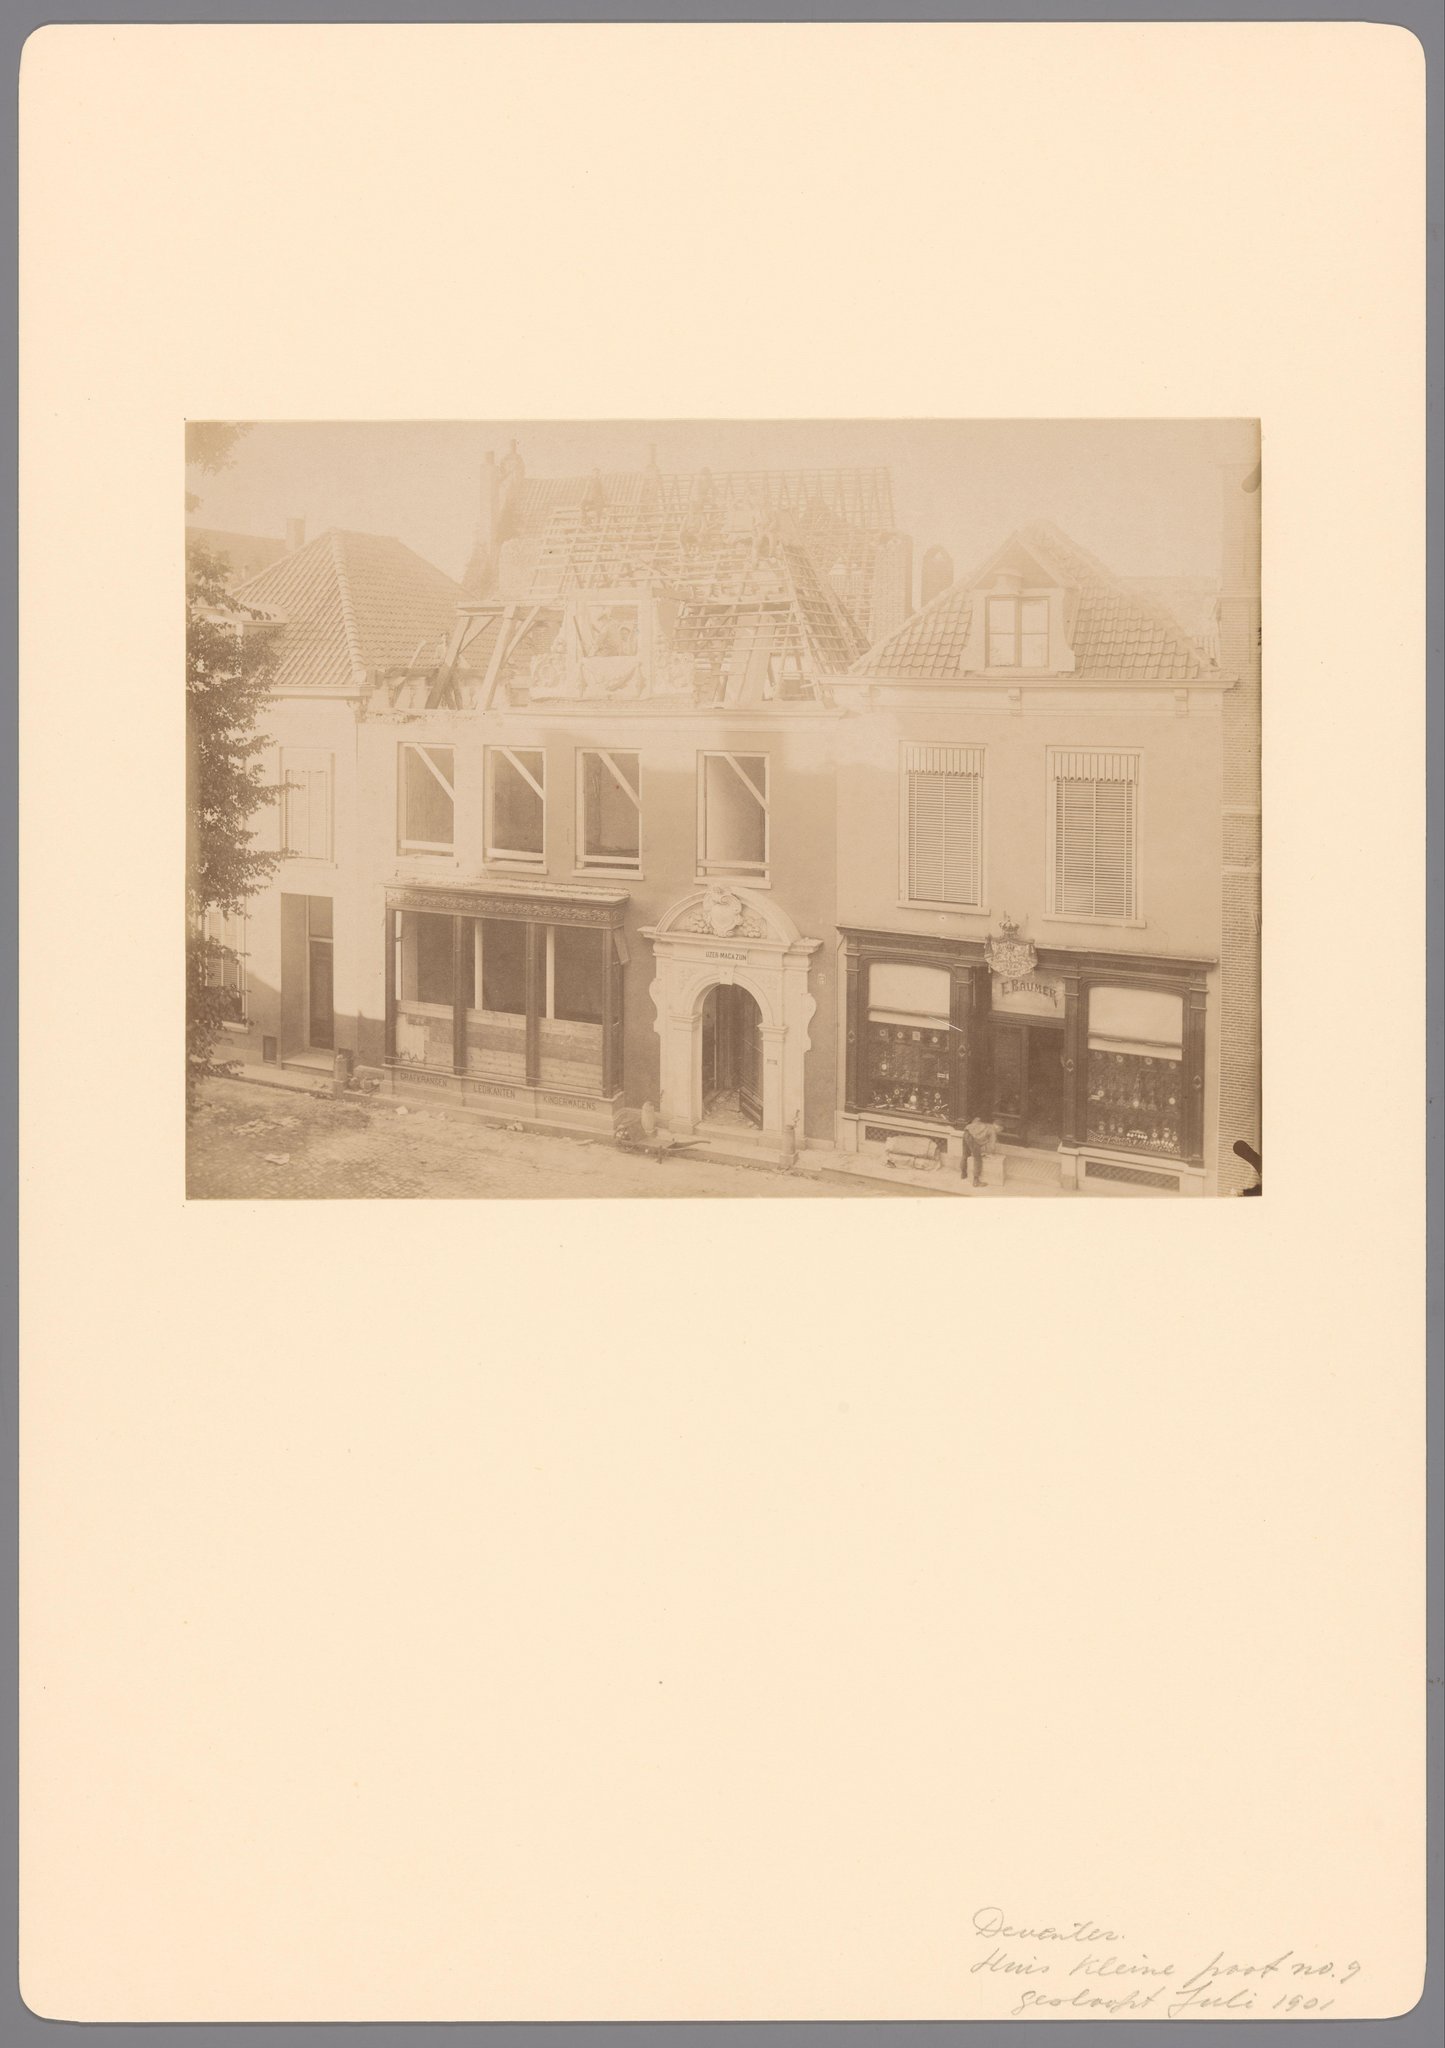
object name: photograph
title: Gezicht op Kleine Poot 9 te Deventer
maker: anoniem (monumentenzorg)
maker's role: fotograaf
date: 1901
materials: cardboard, photographic support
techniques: albumen print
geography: deventer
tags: urban housing, façade (of house or building), street (+ city(-scape) with figures, staffage), deventer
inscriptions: annotation: ‘Deventer/ Huis Kleine Poot 9/ gesloopt juli 1901’